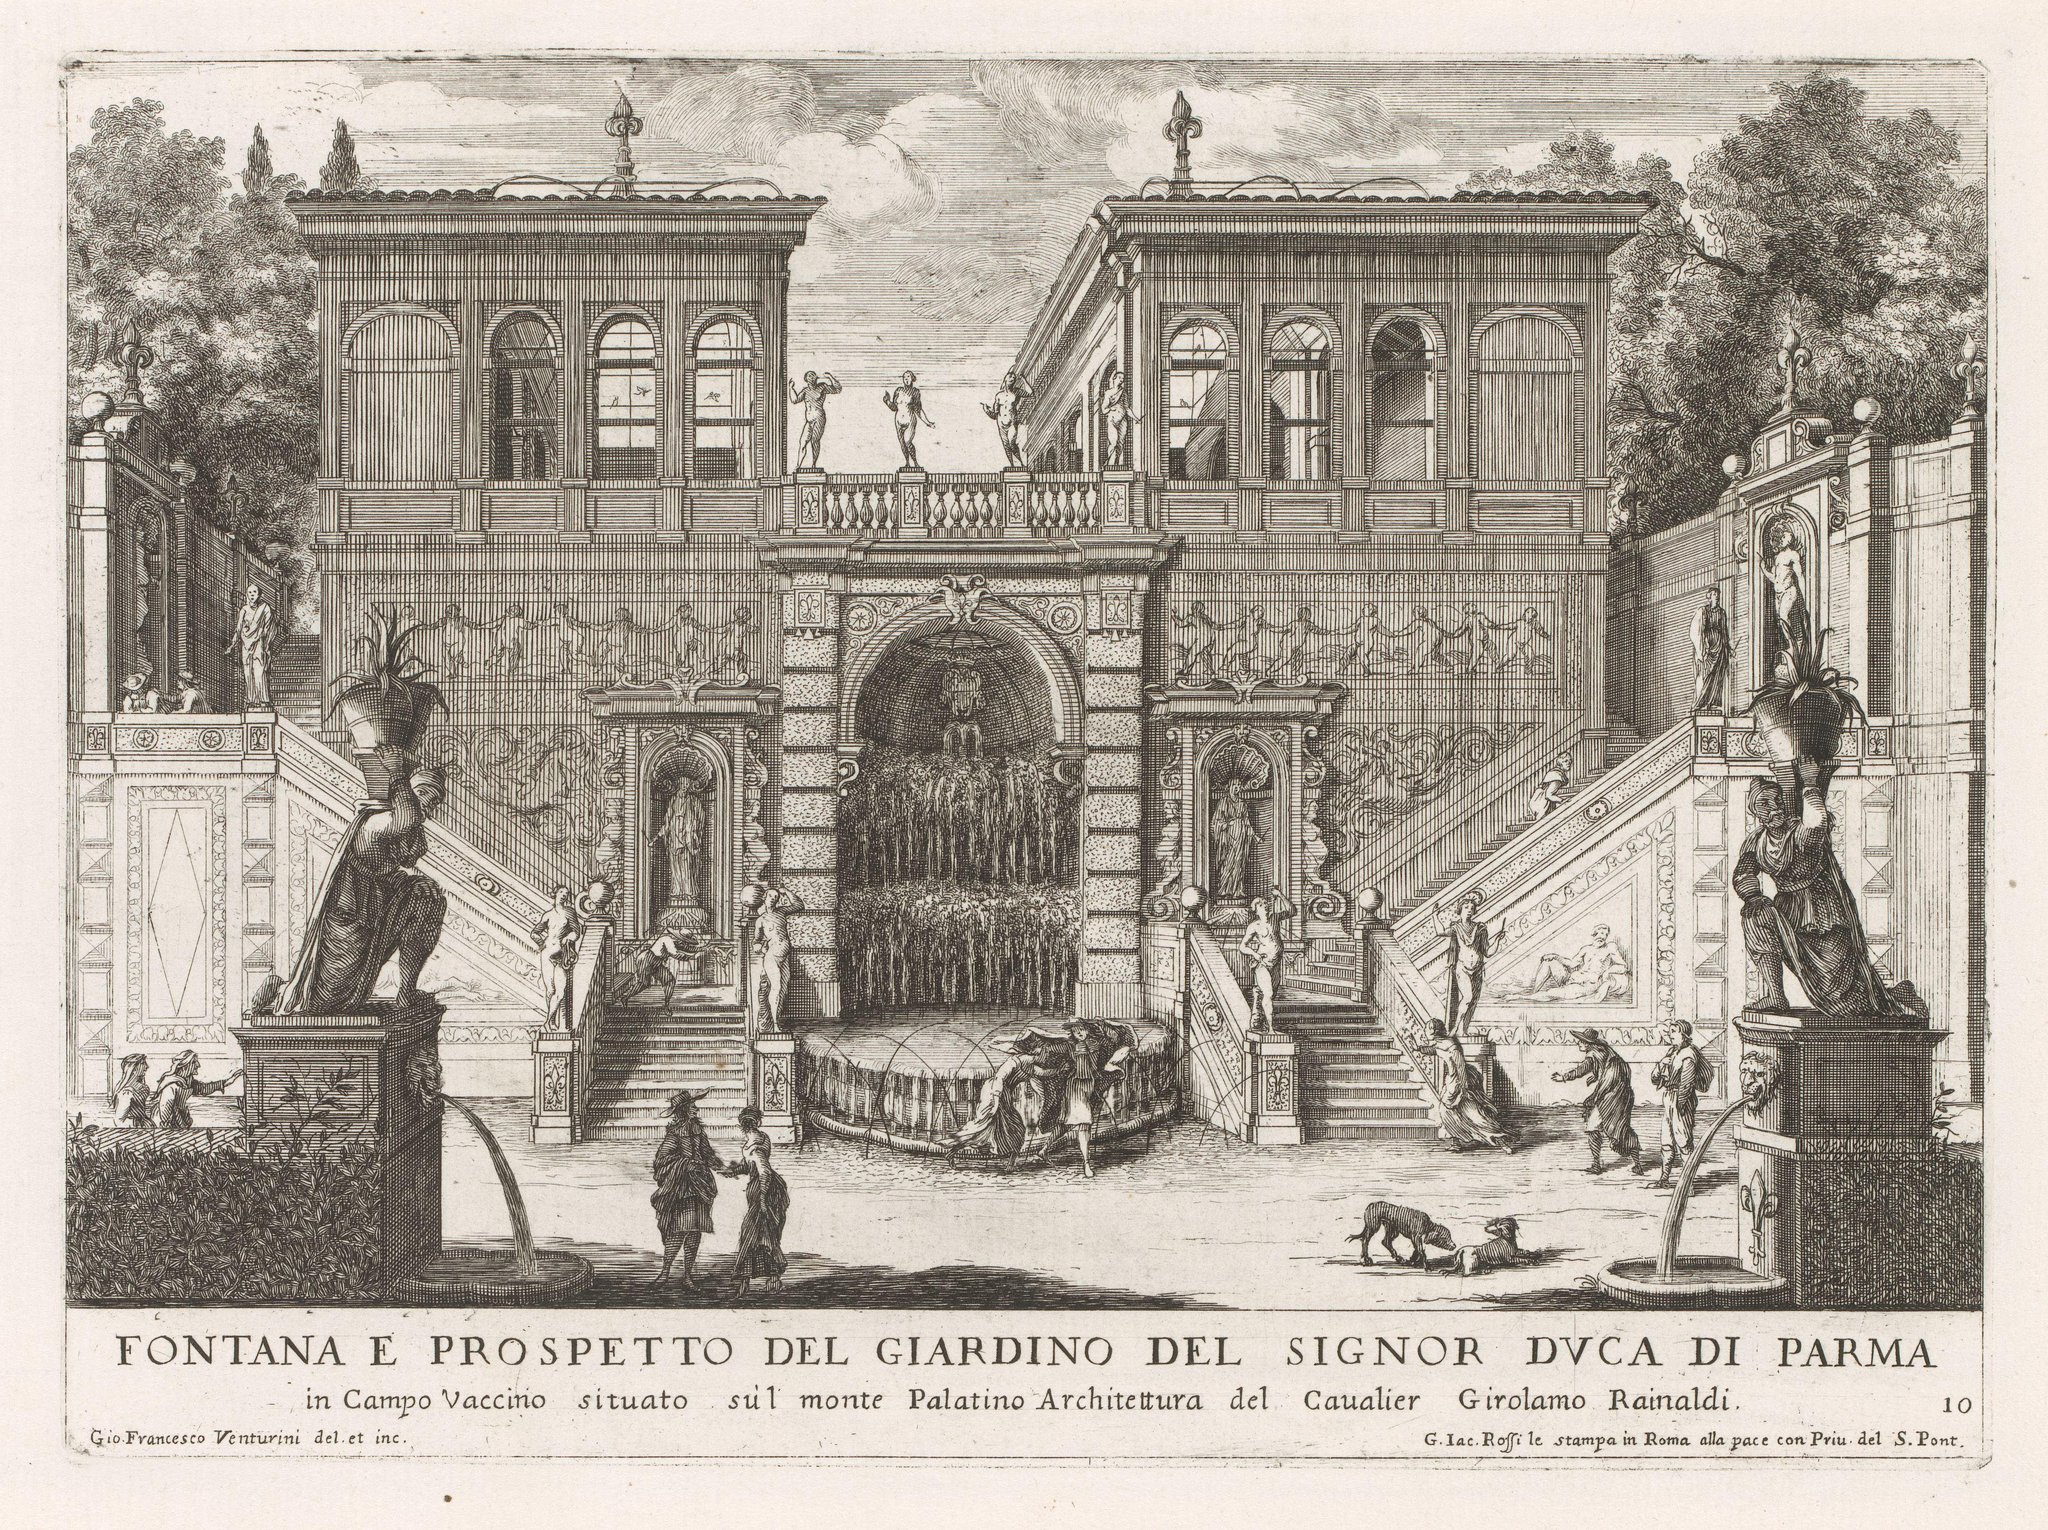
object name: print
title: Fonteinen in de paleizen en tuinen van Rome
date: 1653-1691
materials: paper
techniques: etching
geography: italy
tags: piece of sculpture, reproduction of a piece of sculpture, ornamental fountain, rome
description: Genummerd rechtsonder: 10. De prent maakt deel uit van een album.